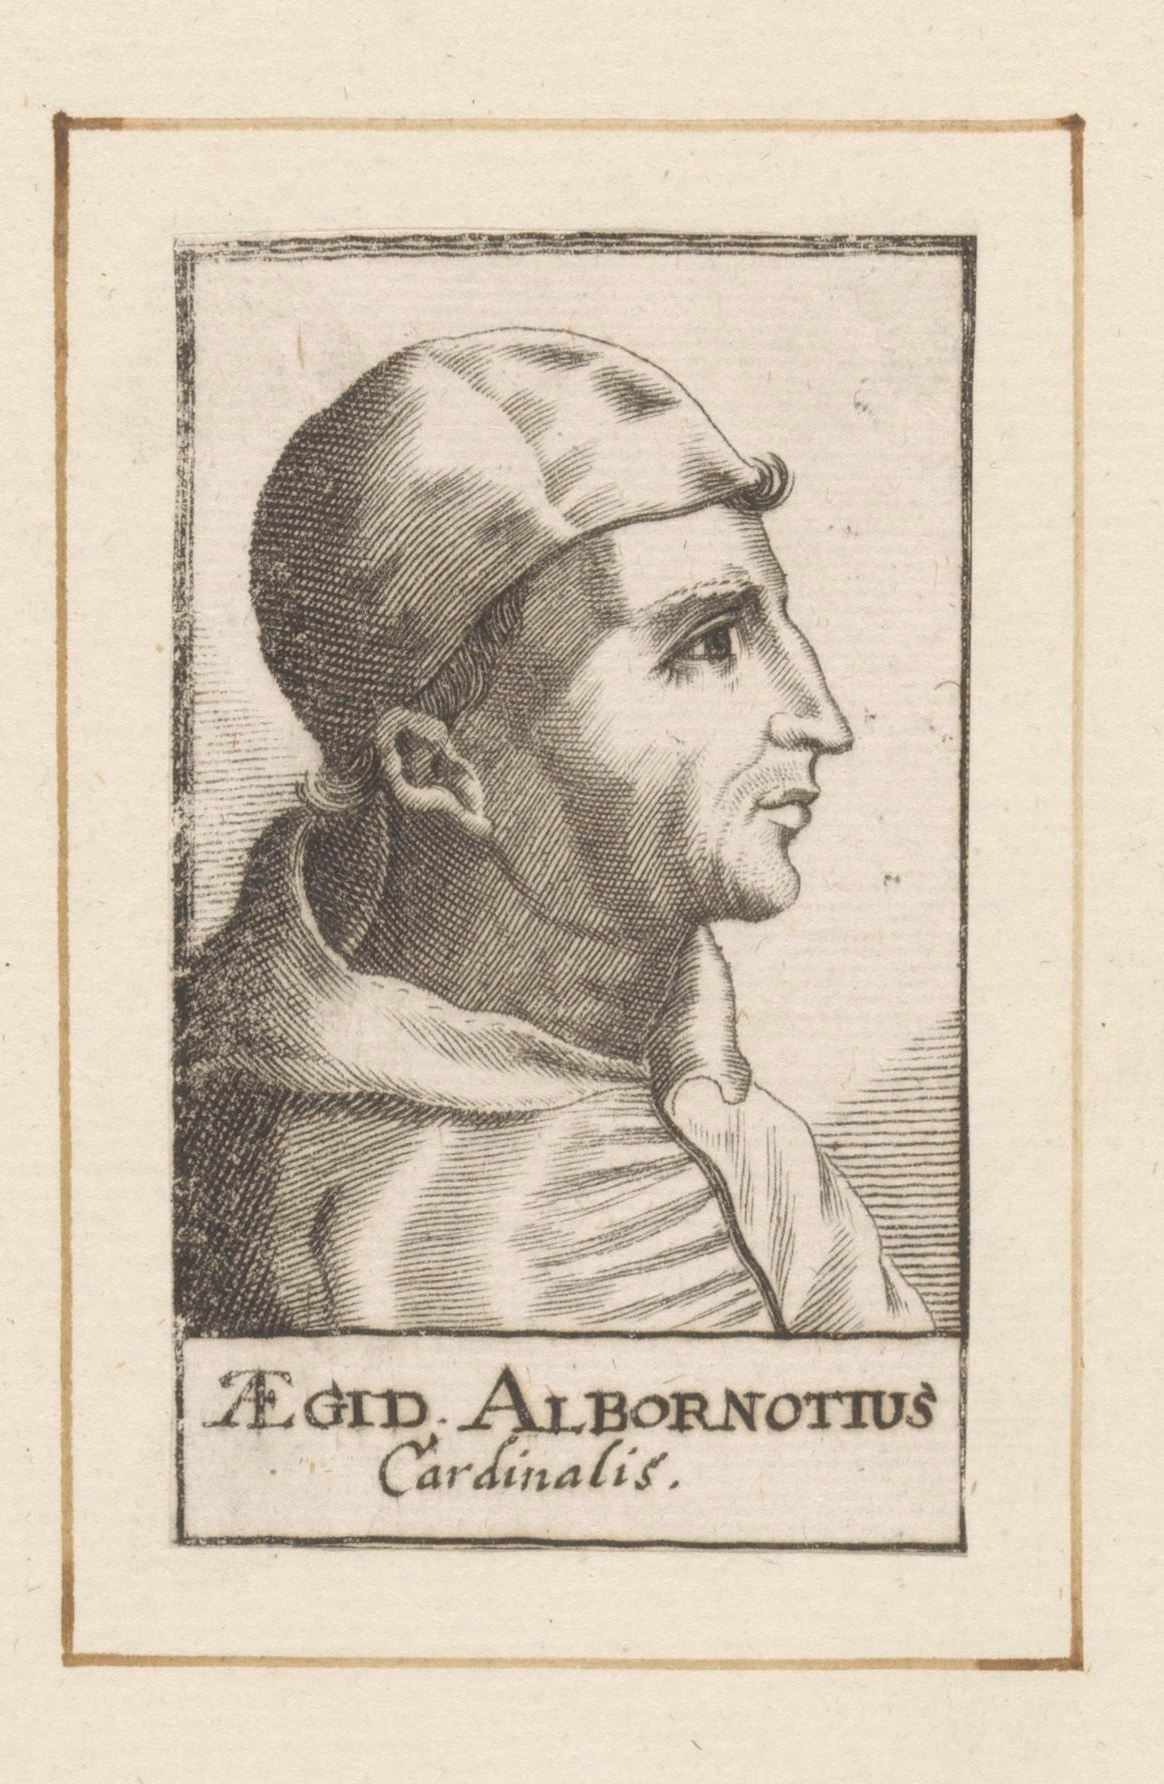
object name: print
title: Portret van kardinaal Gil Álvarez Carrillo de Albornoz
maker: Anonymous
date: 1600-1699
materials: paper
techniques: engraving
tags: gil álvarez carrillo de albornoz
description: Portret van kardinaal Gil Álvarez Carrillo de Albornoz in een rechthoekige omlijsting. In een kader zijn naam en titel.